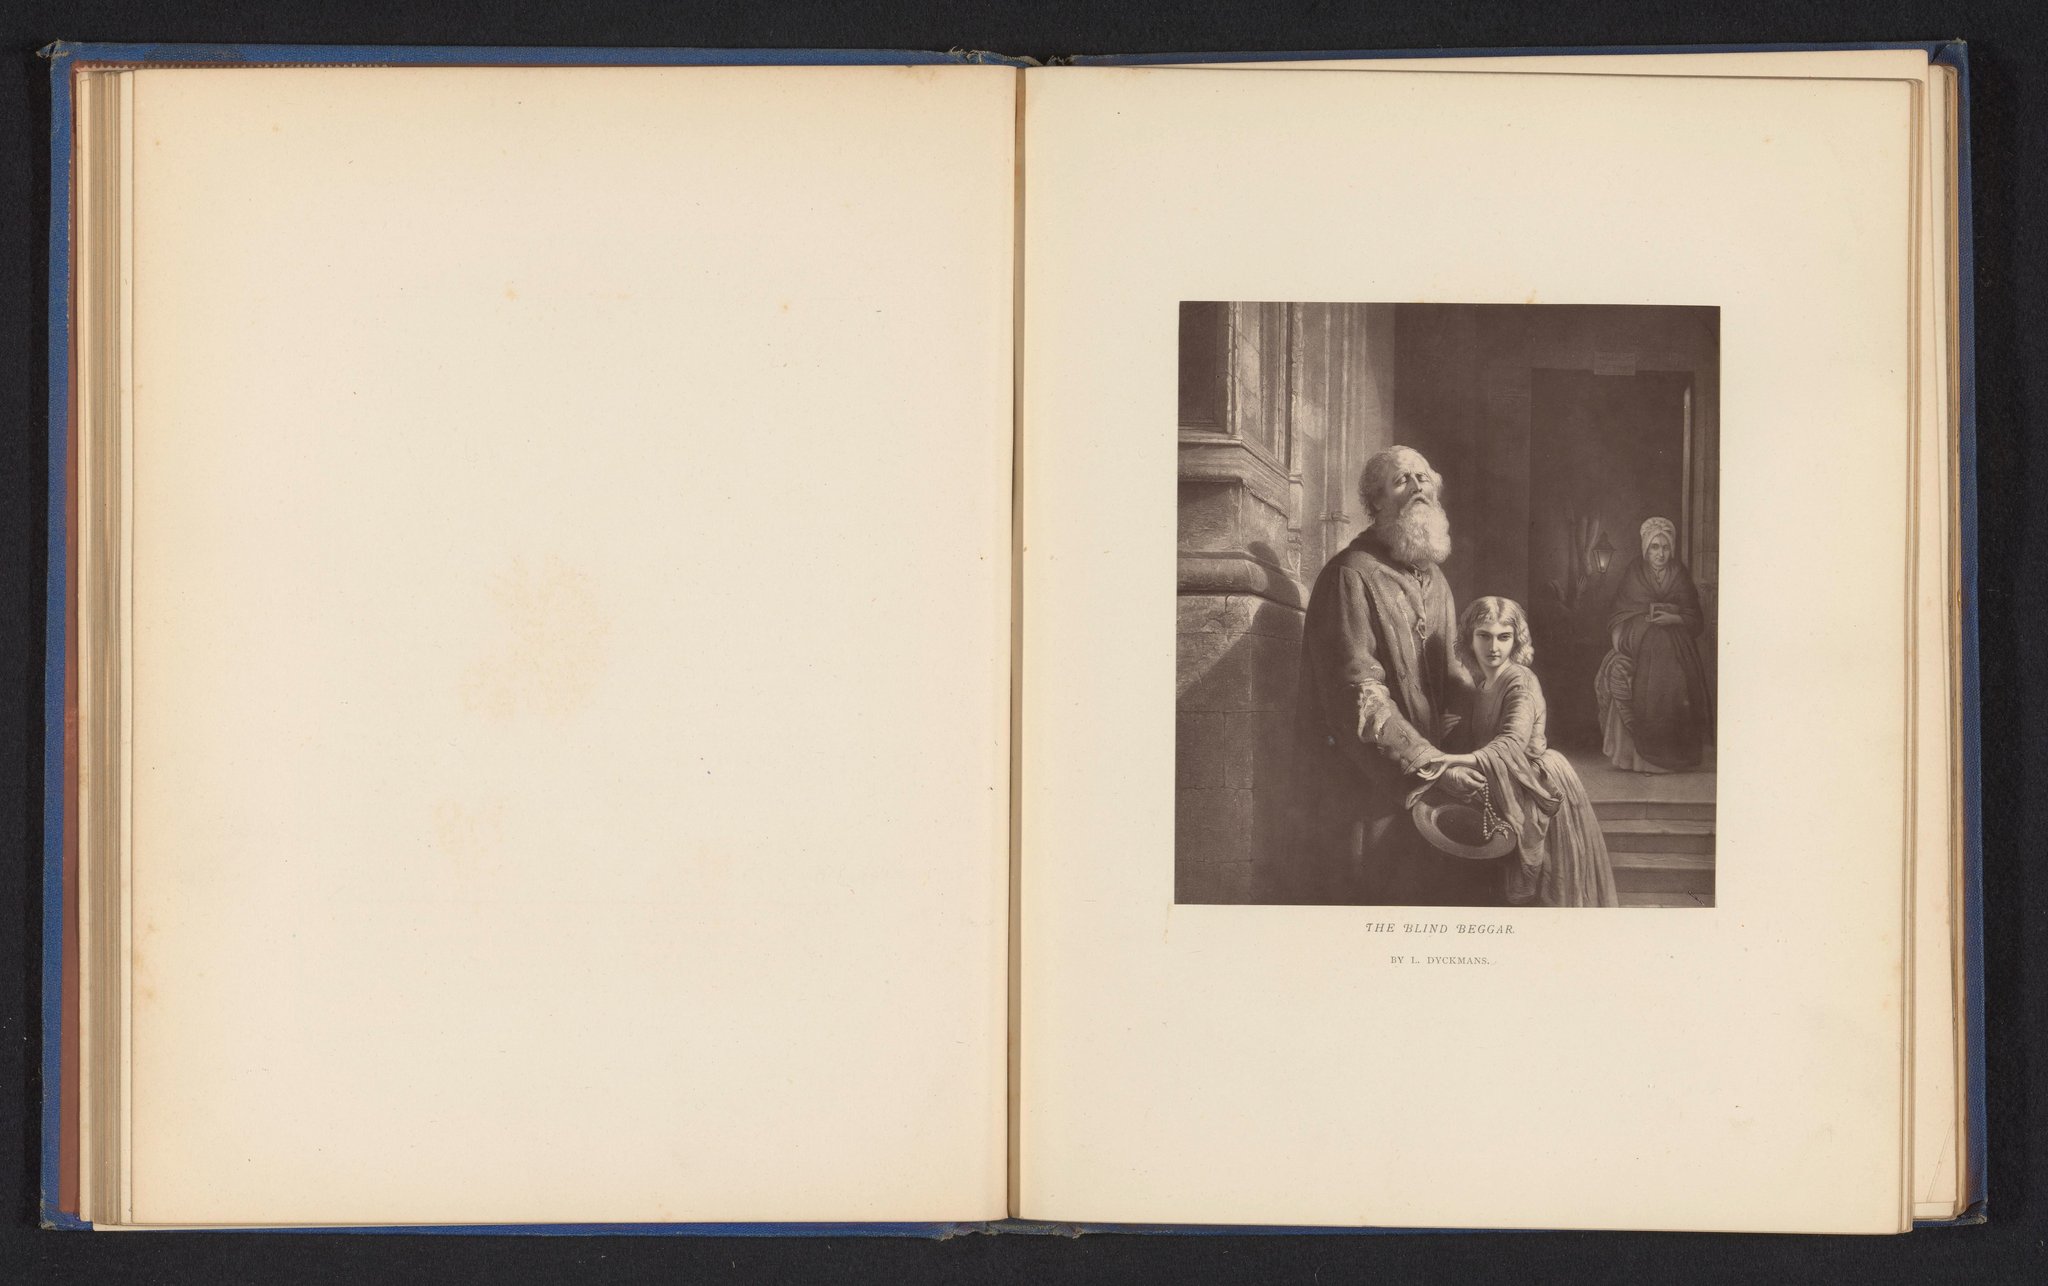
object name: page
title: The blind beggar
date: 1862-1872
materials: paper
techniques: woodburytype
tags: blind, blindness, beggar